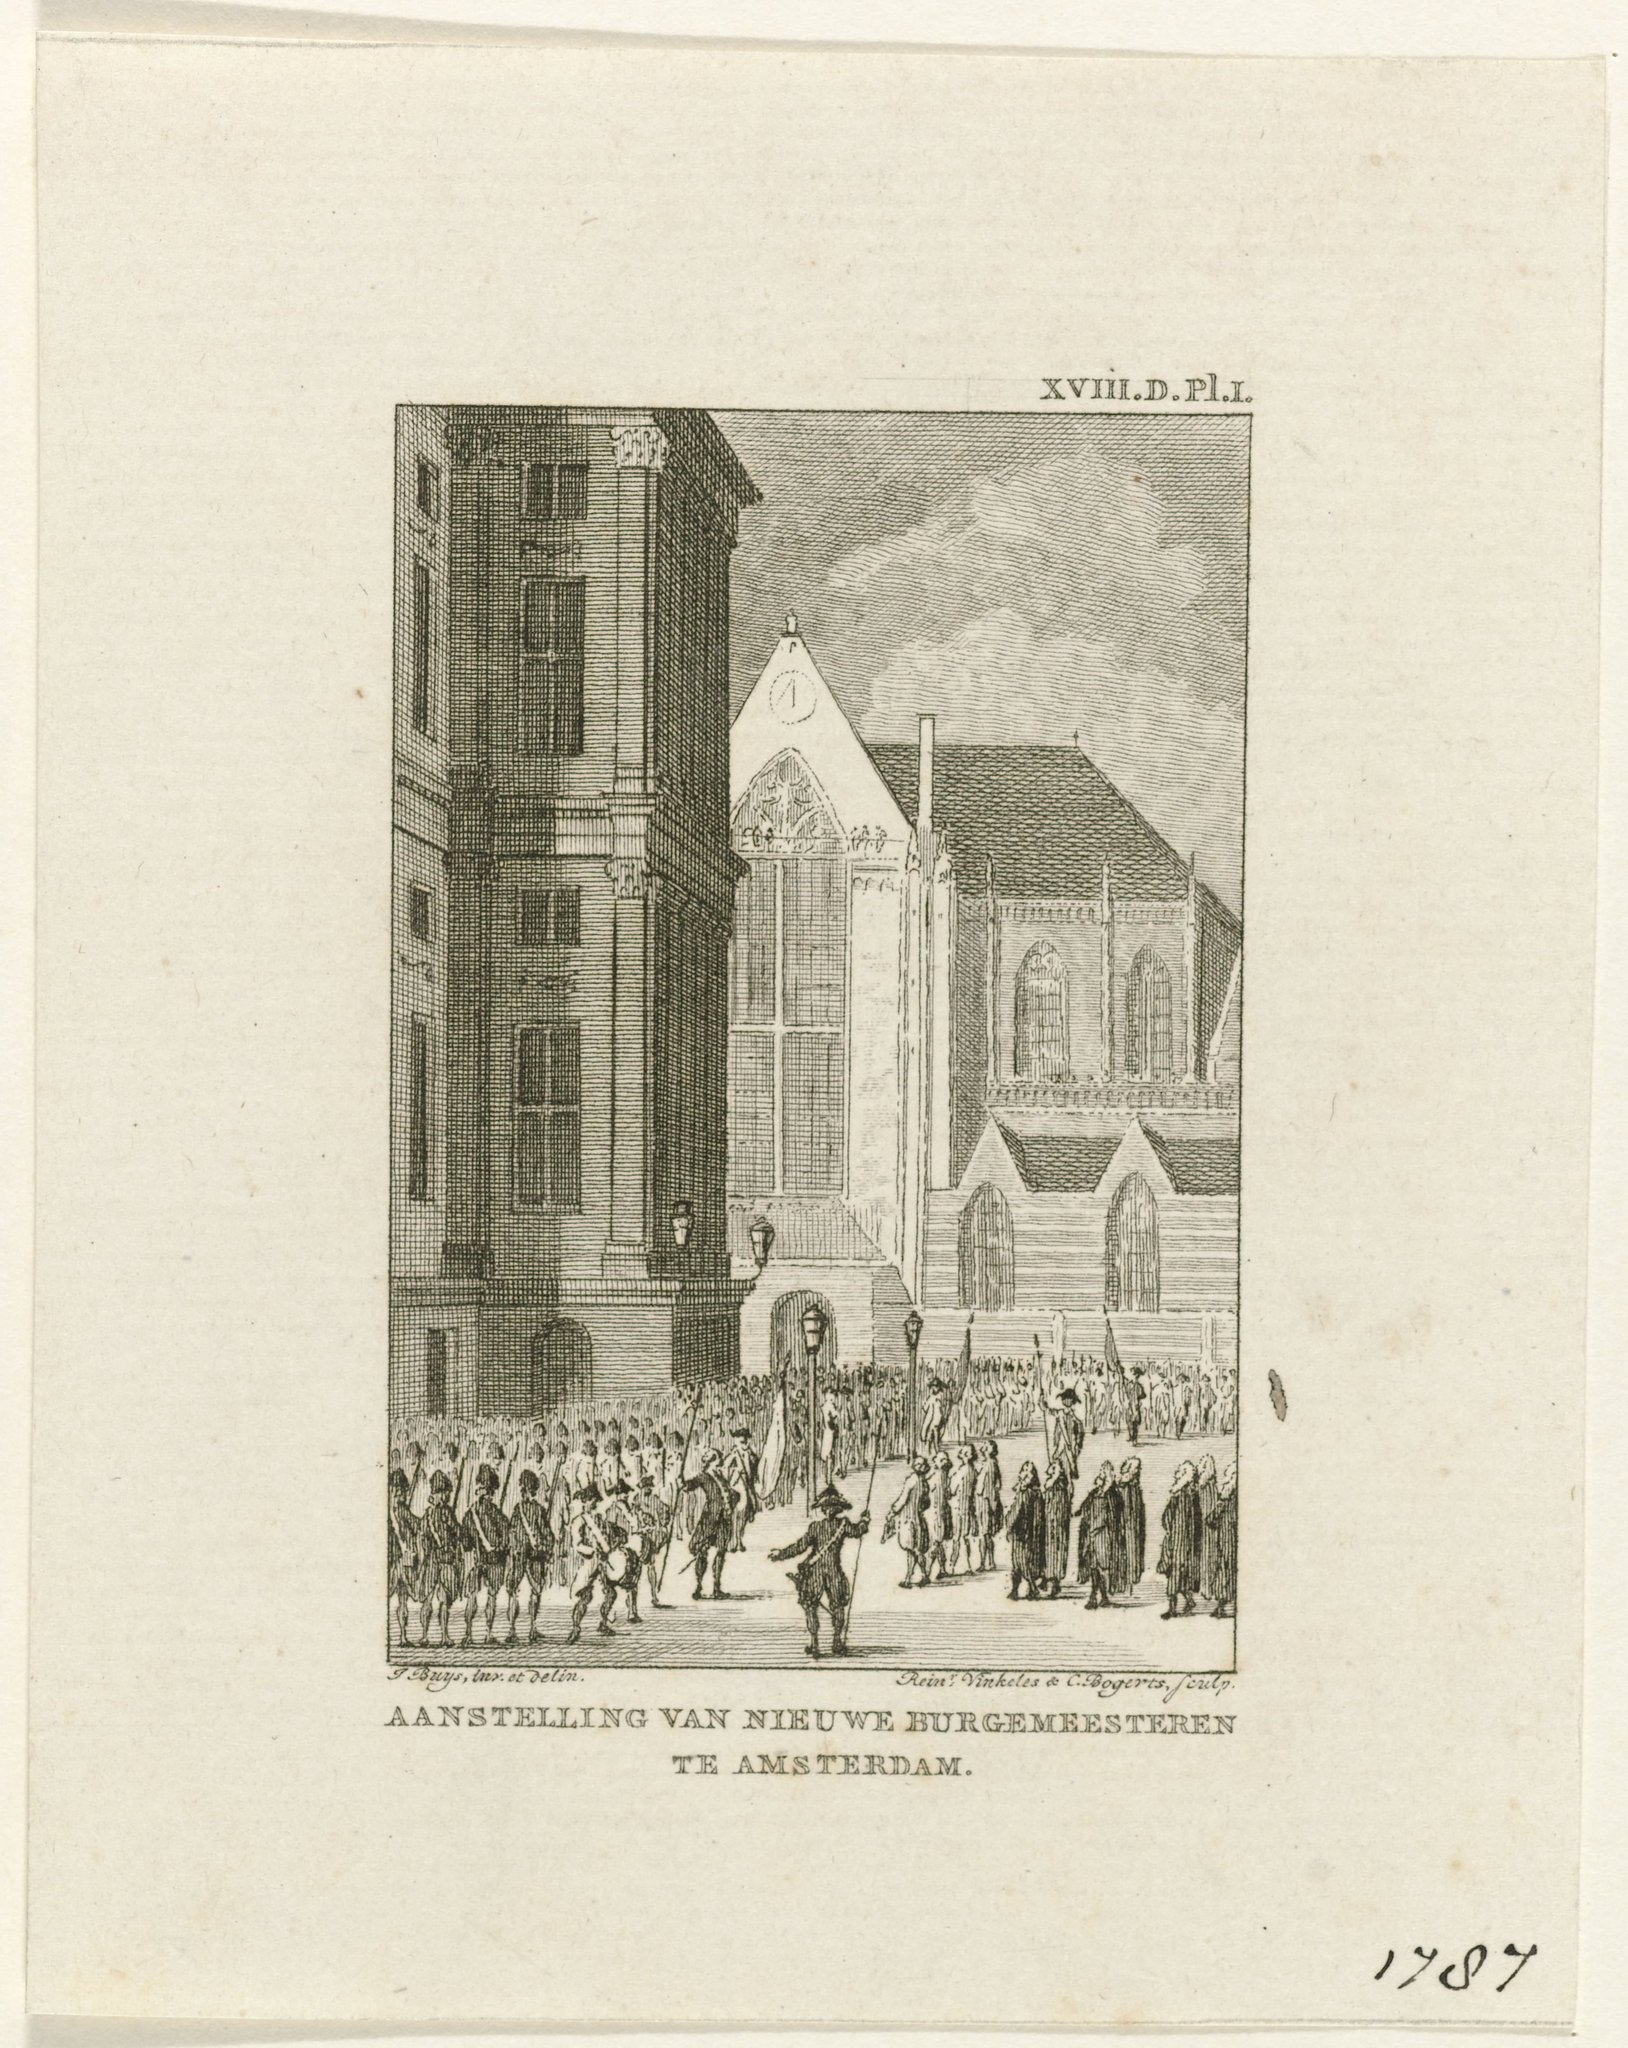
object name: print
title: Aanstelling van twee nieuwe burgemeesters te Amsterdam, 1787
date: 1787-1795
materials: paper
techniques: engraving, etching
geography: northern netherlands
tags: nieuwe kerk, dam, stadhuis van amsterdam (1655-1808)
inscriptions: collector's mark: Lugt 2228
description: Plechtige ceremonie voor een groot publiek op de Dam voor het stadhuis bij de verkiezing van twee nieuwe burgemeesters te Amsterdam, 7 juli 1787. Gemerkt rechtsboven: XVIII.D.Pl.I.